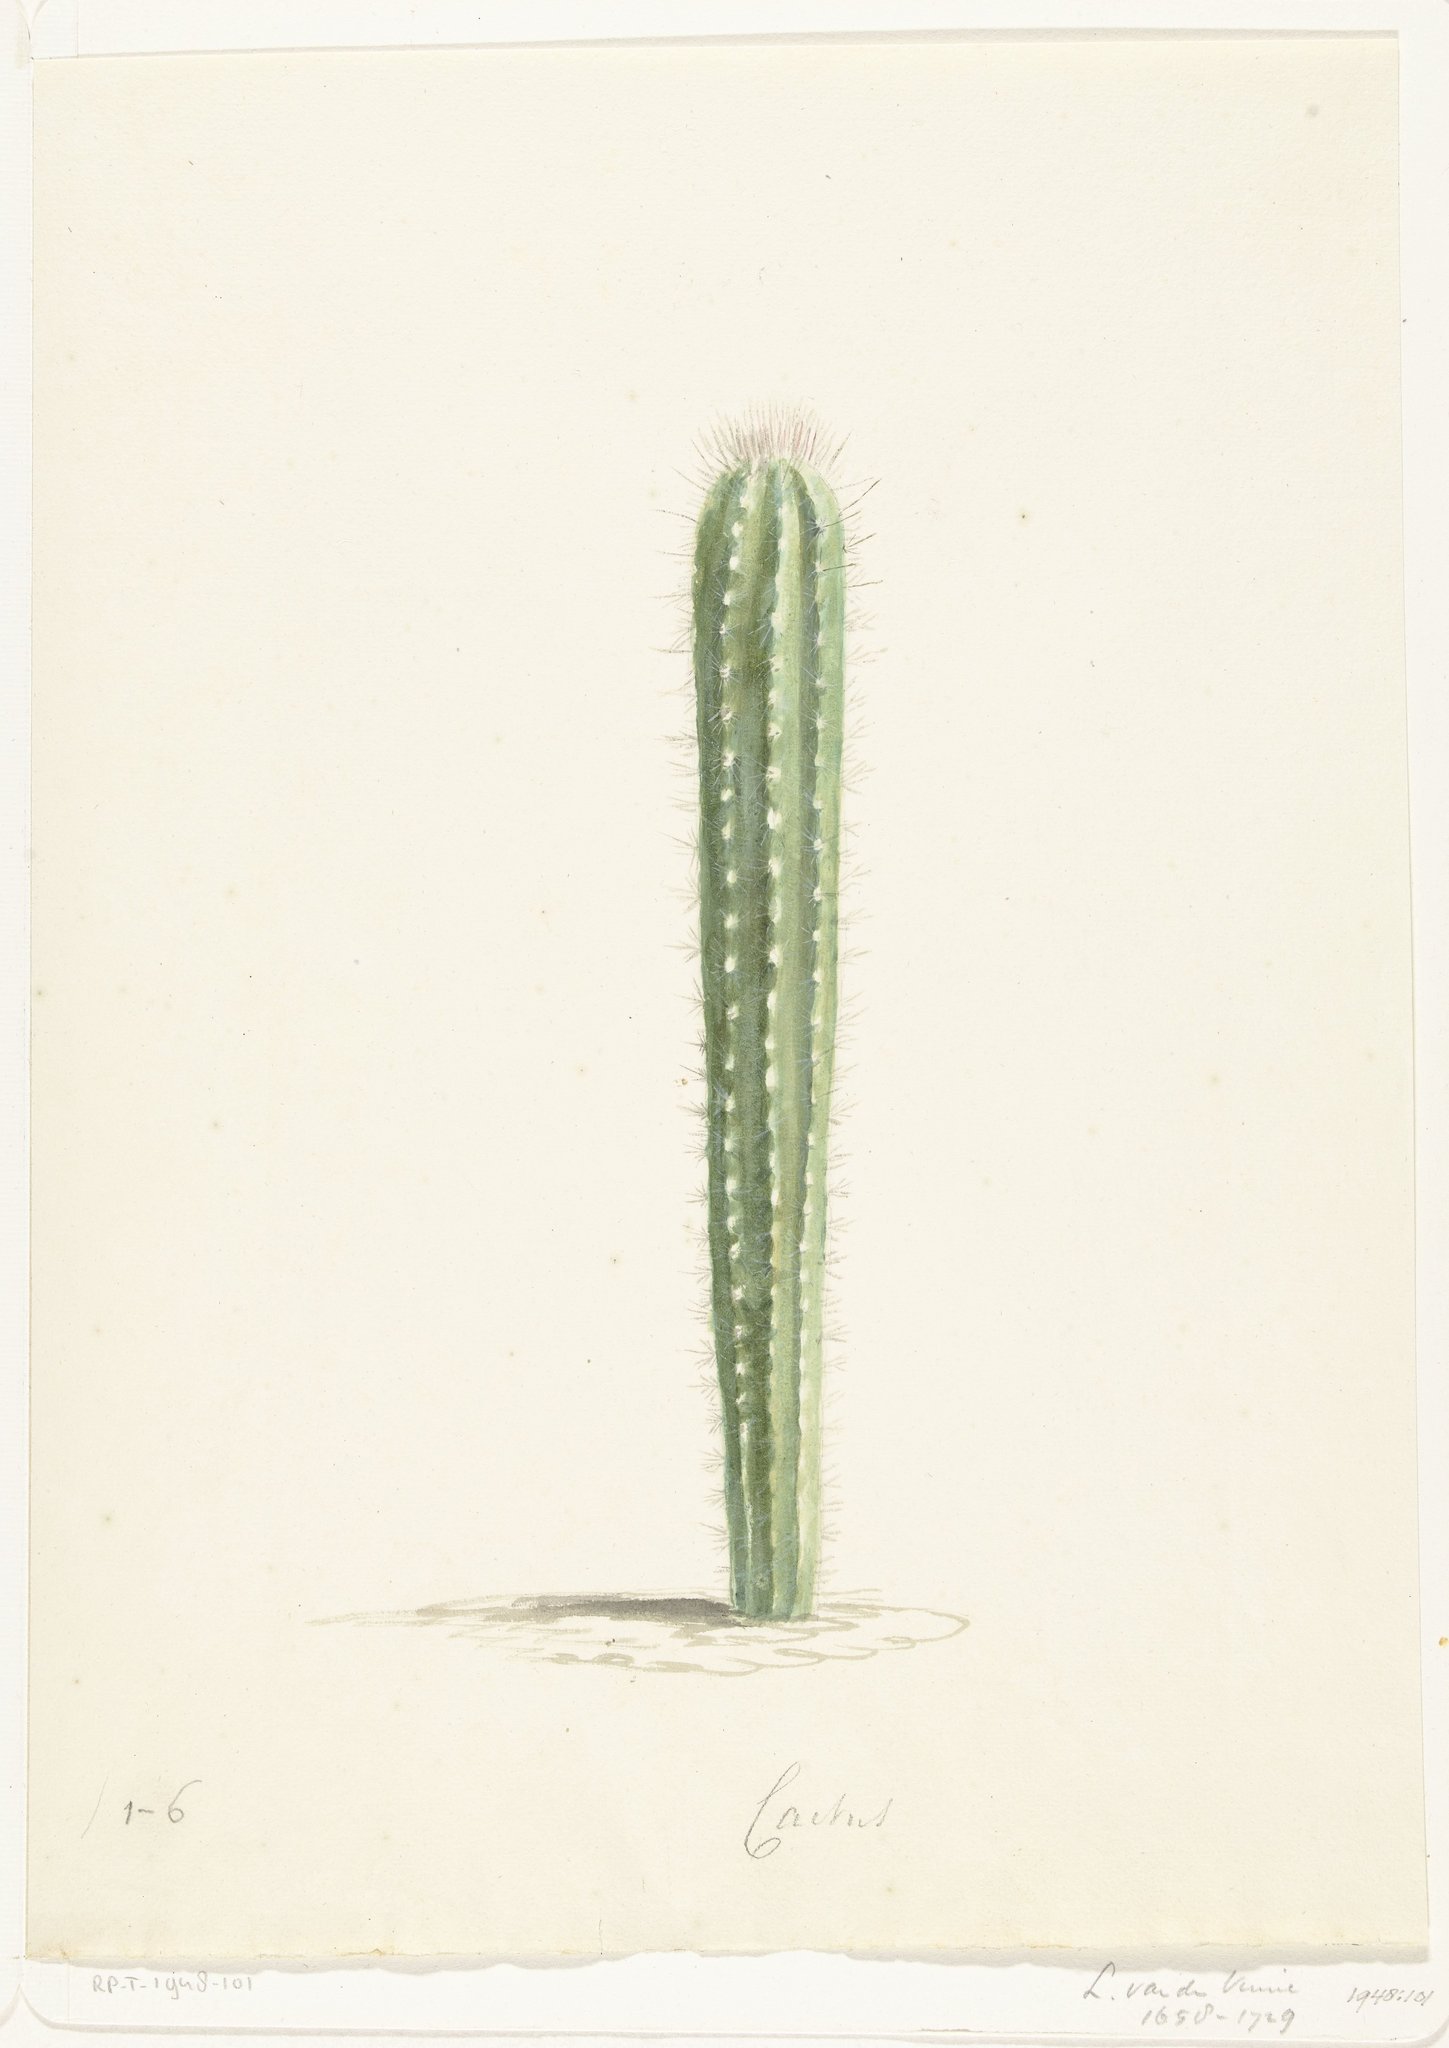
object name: drawing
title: Cactus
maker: laurens vincentsz. van der vinne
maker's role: draughtsman, print maker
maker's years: 1658-1729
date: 1668-1729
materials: gouache, paper, watercolor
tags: plants and herbs: cactus